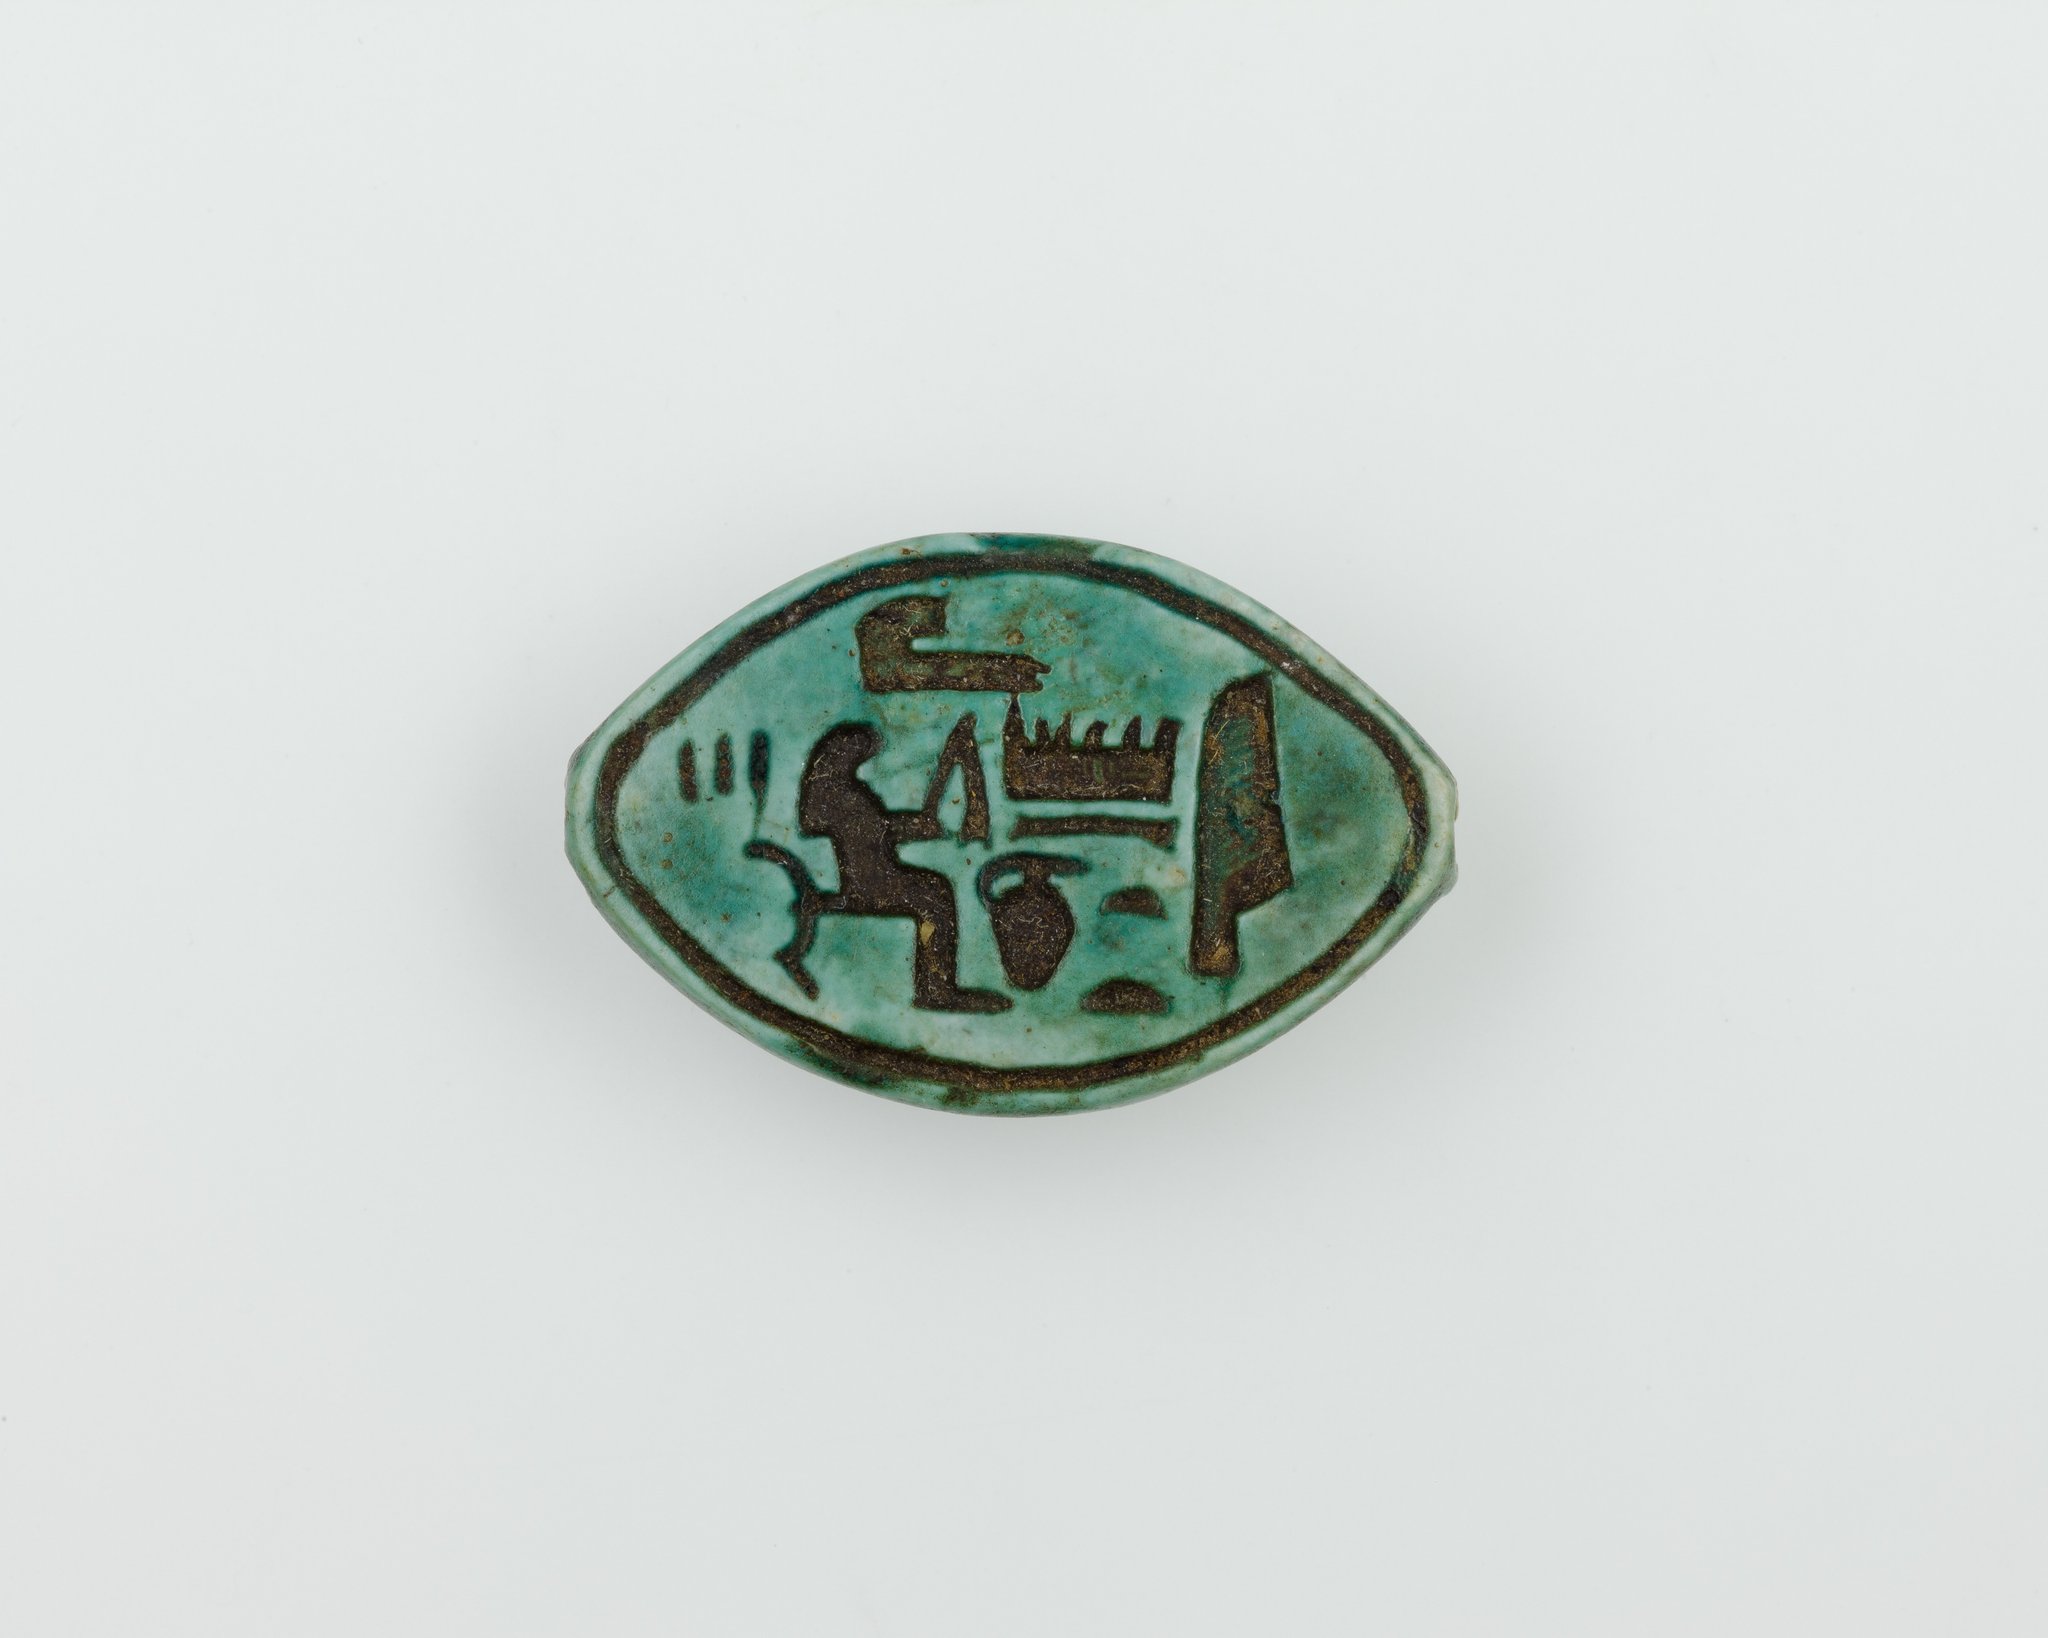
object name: cowroid, hatshepsut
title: Cowroid with the Name and Image of Hatshepsut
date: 1479-1458 BCE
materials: stone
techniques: glazing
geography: egypt